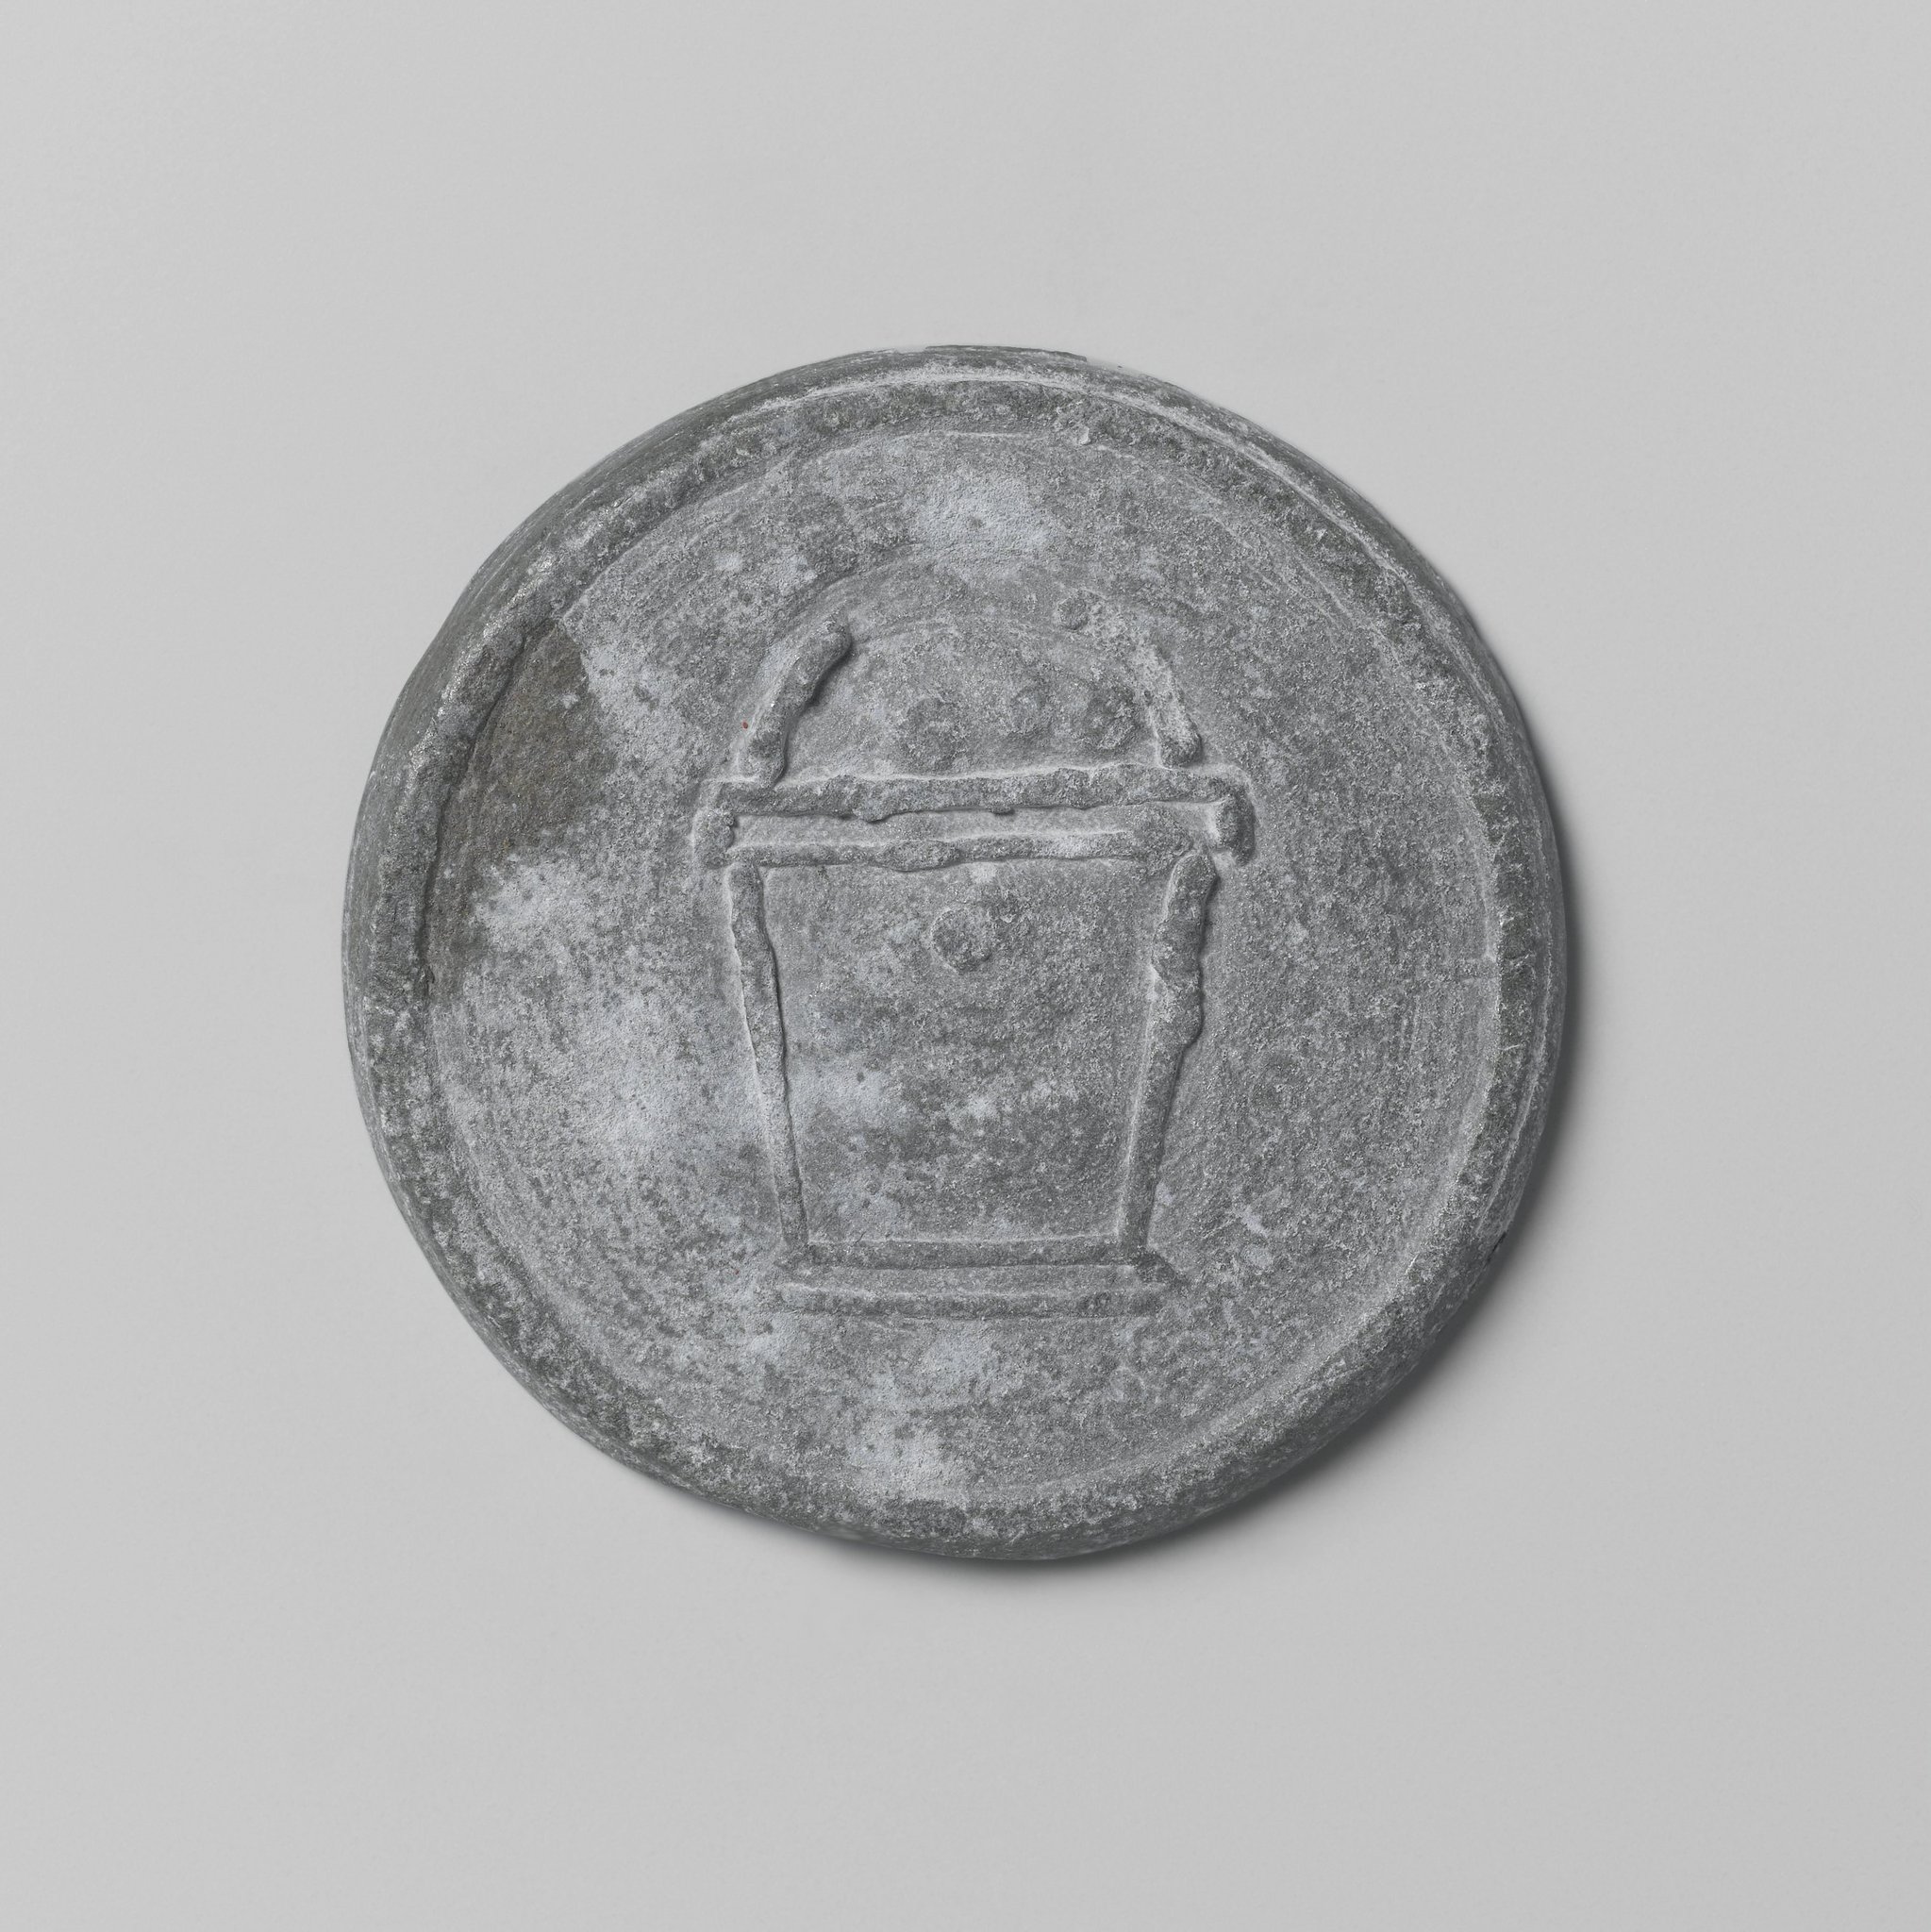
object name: presentiepenning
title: Turfdragersgilde van Amsterdam, presentiepenning met no. 3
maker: Anonymous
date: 1600-1800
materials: lead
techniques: casting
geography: amsterdam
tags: amsterdam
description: Loden penning. Voorzijde: brandemmer. Keerzijde: letters T, D en G; onder D: cijfer 3